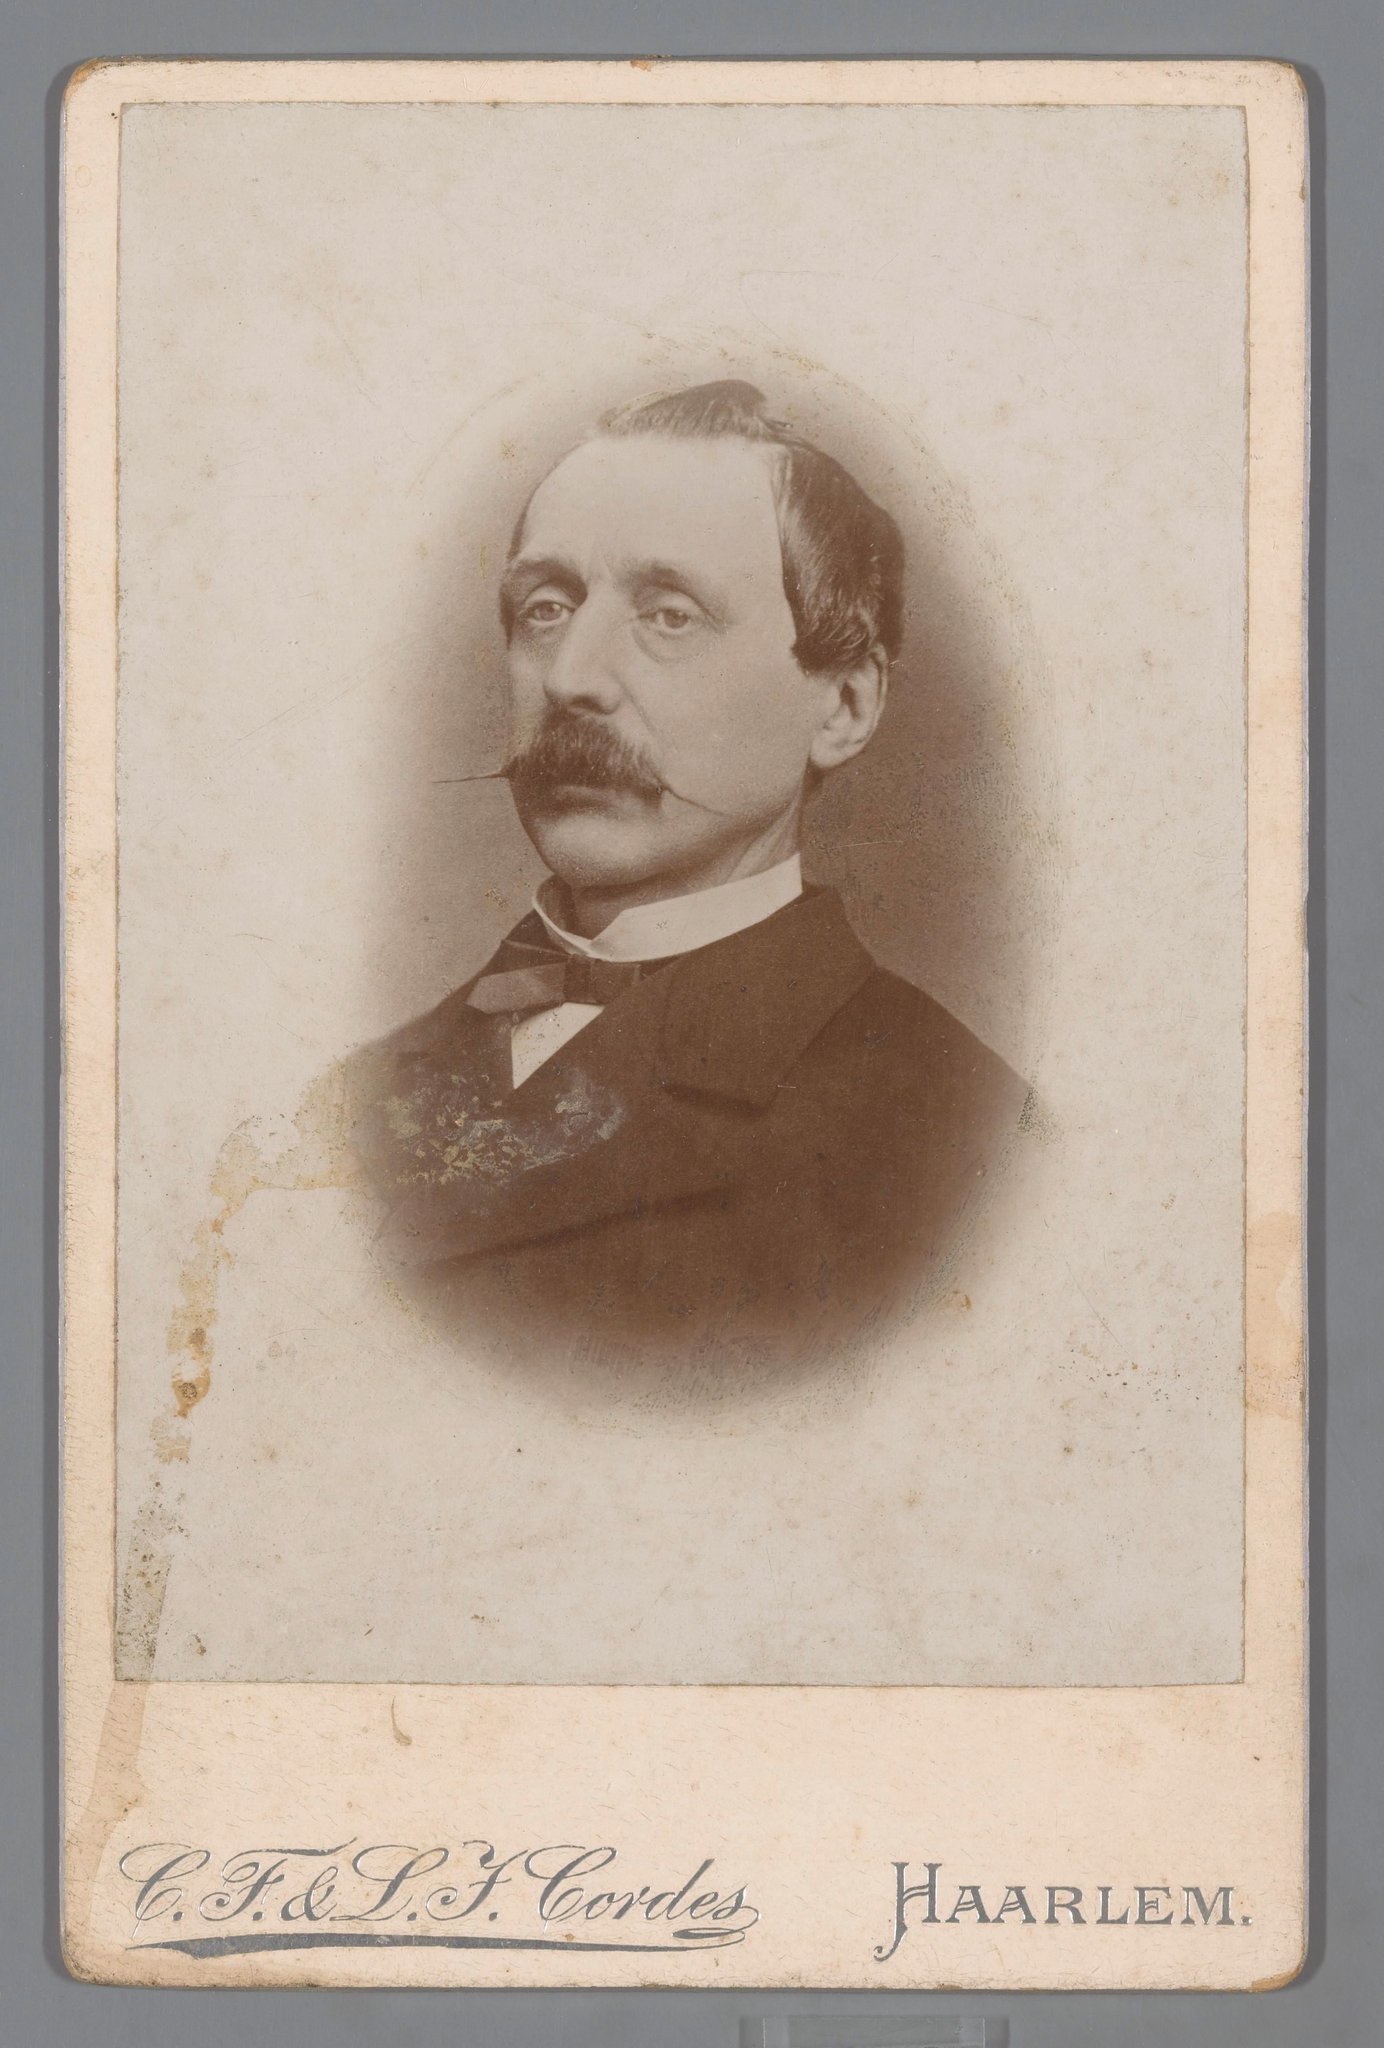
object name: cabinet photograph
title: Portret van een onbekende man met een snor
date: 1881-1901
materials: cardboard, photographic support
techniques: collodion silver print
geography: haarlem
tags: moustache, adult man